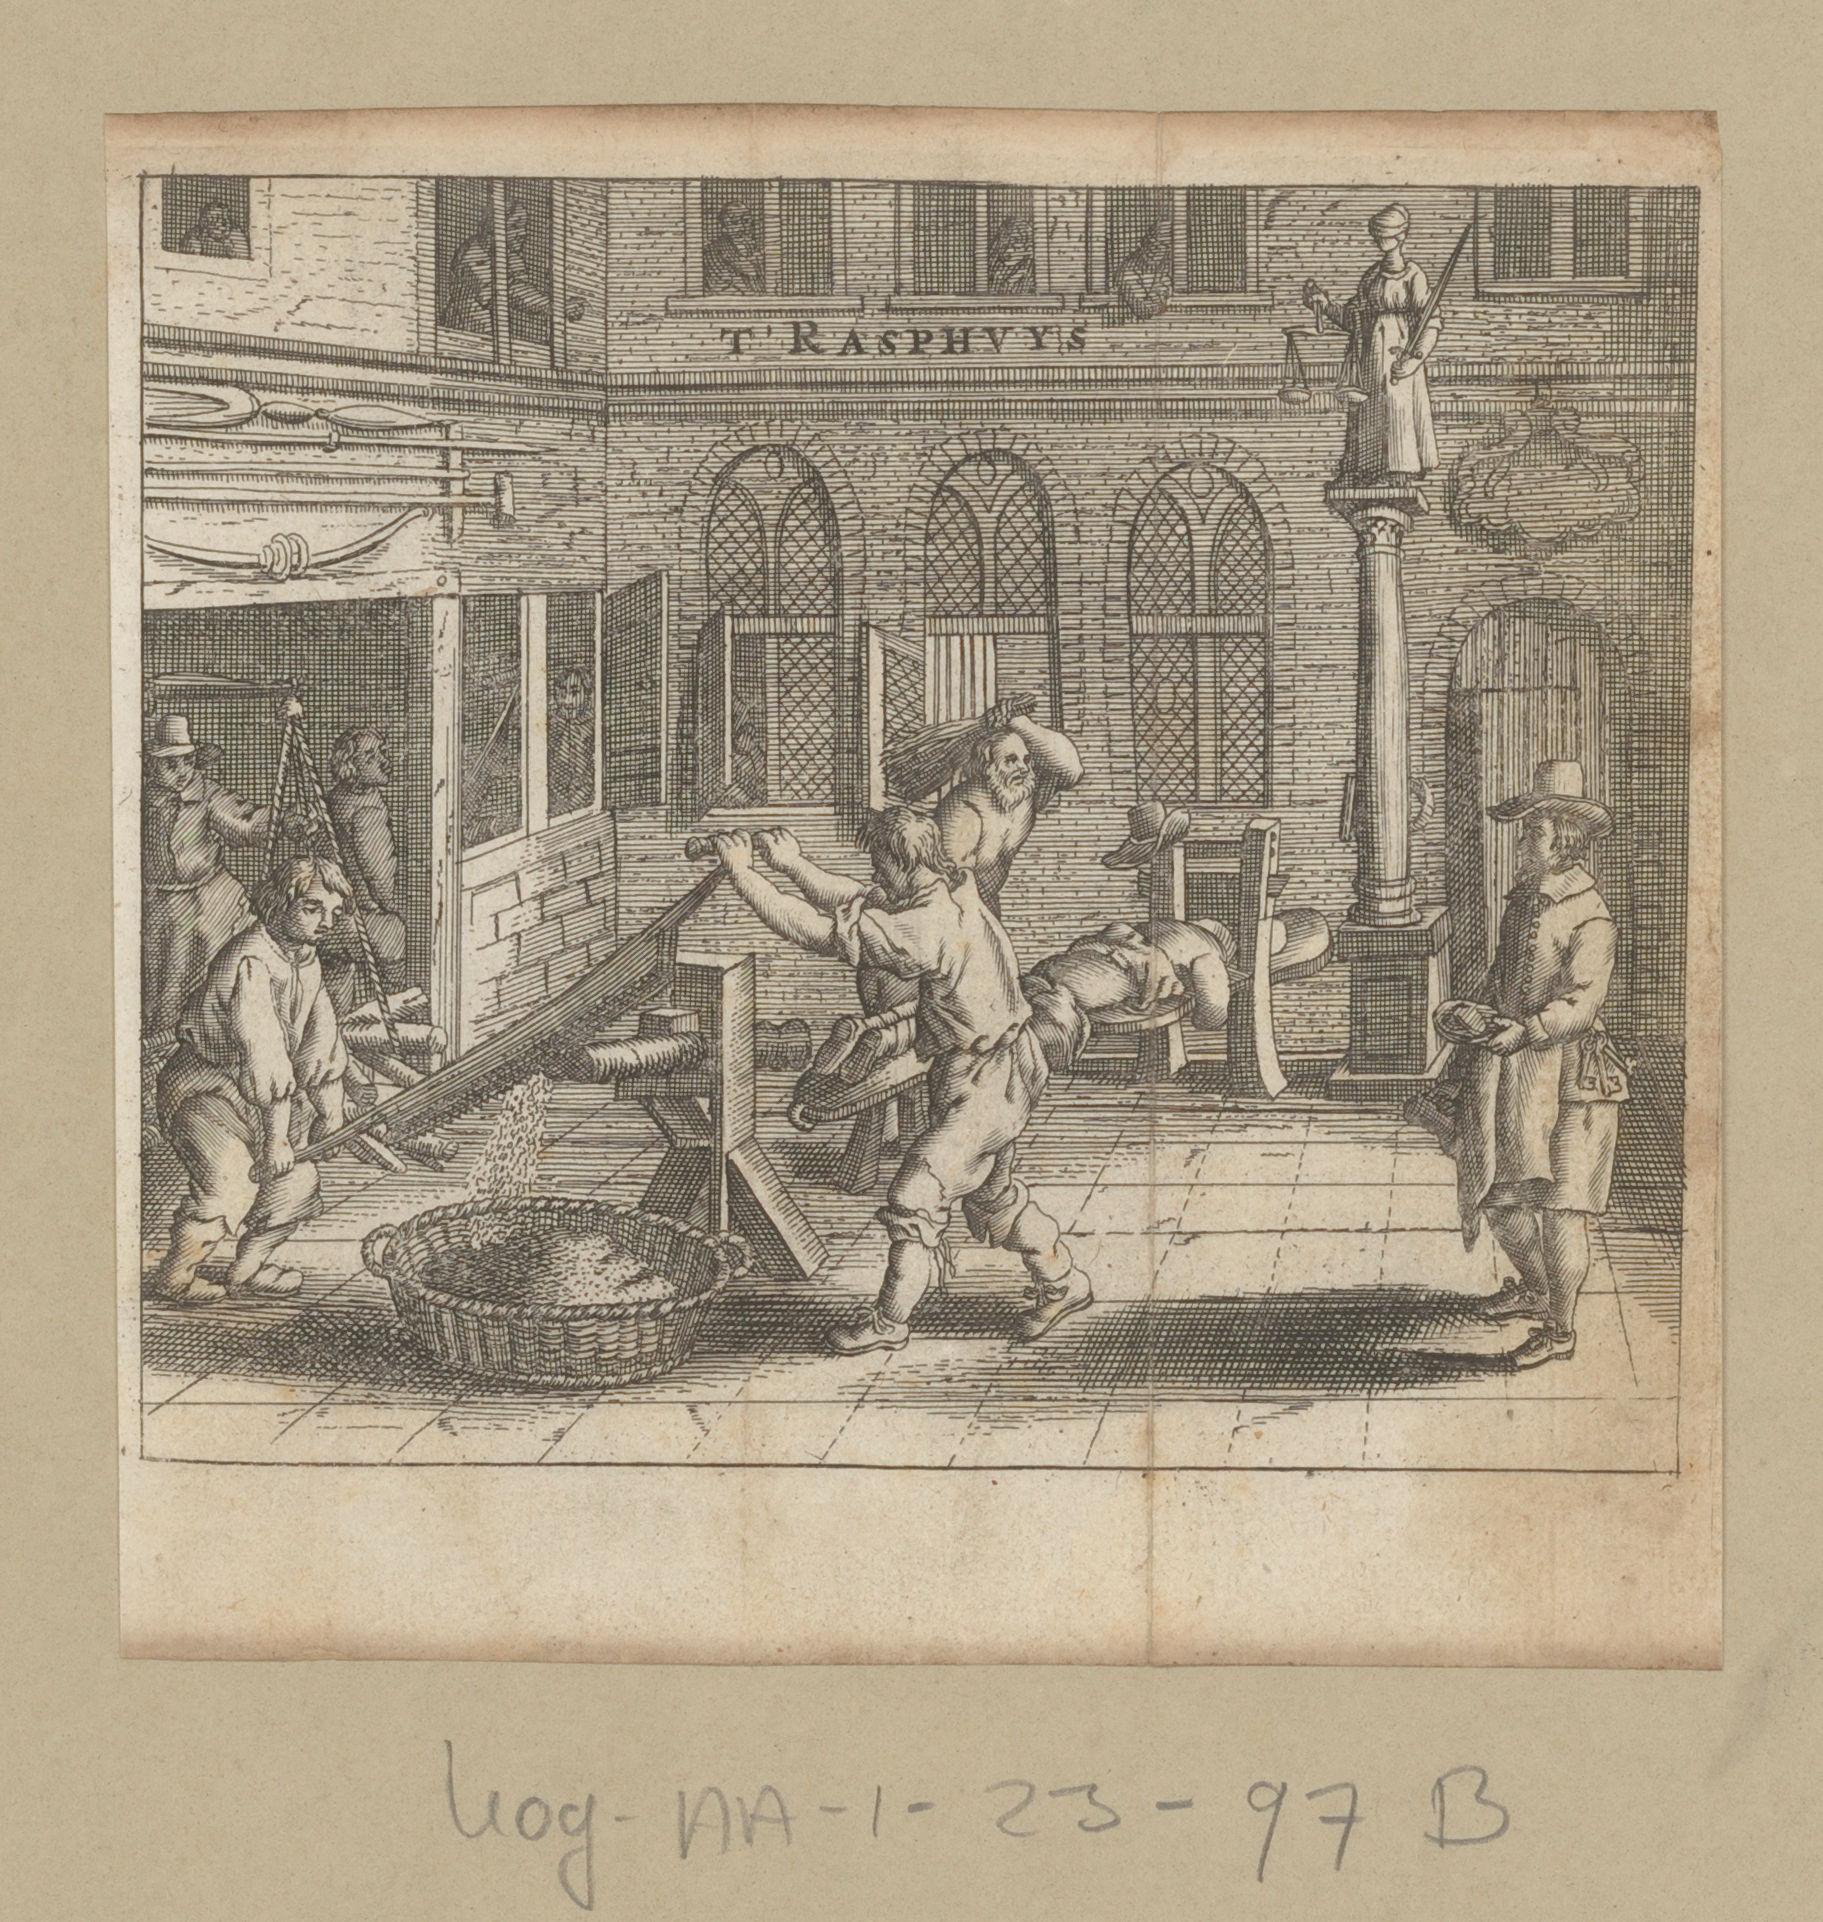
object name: book illustration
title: Gezicht op de binnenplaats van het Rasphuis te Amsterdam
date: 1664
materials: paper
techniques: etching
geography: northern netherlands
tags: prison, jail, (prisoners) in the prison yard, instruments of torture, execution or punishment: birch rod, justitia (justice) as roman personification, workhouse, penal camp, penitentiary, chain gang, sawing (industrial process)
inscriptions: collector's mark: Lugt 1641b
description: Huidige staat van prent ook gebruikt in: Fockens, Melchior. Beschrijvingh Der wijdt-vermaarde Koop-stadt Amstelredam (…). 3de druk. Amsterdam: Marcus Willemsz. Doornick, 1664. En in: Zesen, Philipp von. Beschreibung der Stadt Amsterdam (…). Amsterdam: Marcus Willemsz. Doornick, 1664. Eerste bekende staat van prent (rechtsonder genummerd: 276) ook gebruikt in: Fockens, Melchior. Beschrijvinge Der wijdt-vermaarde Koop-stadt Amstelredam (…). 1ste druk. Amsterdam: Marcus Willemsz. Doornick, 1662. En in: Fockens, Melchior. Beschrijvinge Der wijdt-vermaarde Koop-stadt Amstelredam (…). 2de druk. Amsterdam: Marcus Willemsz. Doornick, 1662. Derde bekende staat (met toevoeging Franse titel) ook gebruikt in: Domselaer, Tobias en Isaac Commelin. Beschryvinge van Amsterdam (…). 6 dln. Amsterdam: Marcus Willemsz. Doornick, 1665, dl. 4, p. 103. Vierde bekende staat (rechtsboven genummerd: 34) ook gebruikt in verschillende latere zeventiende- en achttiende-eeuwse publicaties.